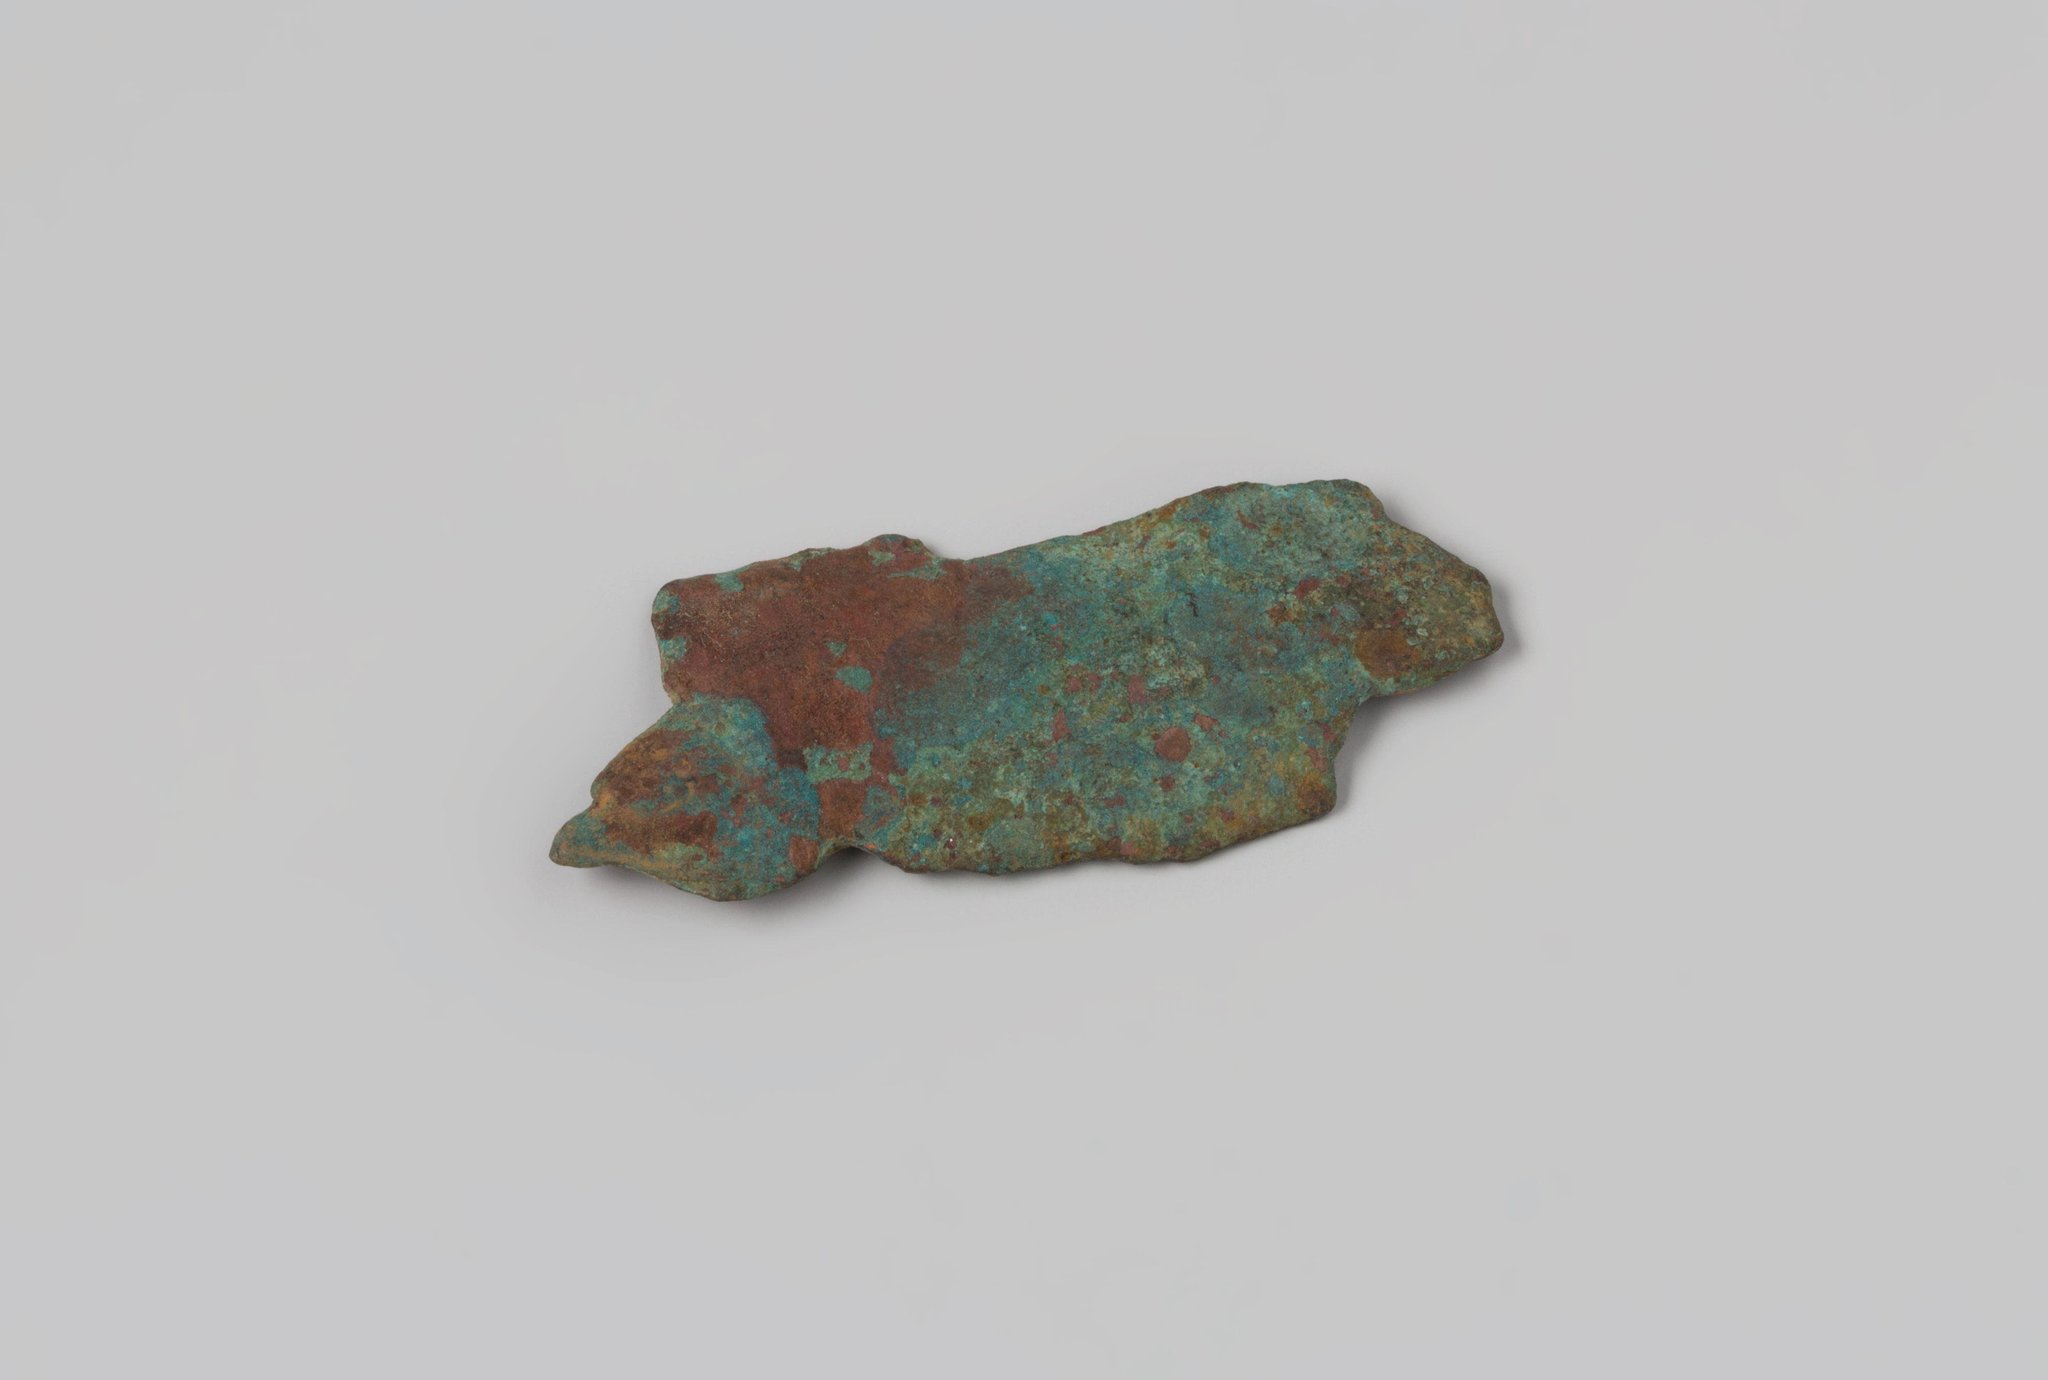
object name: scheepswrakvondst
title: Fragment van koper uit het wrak van de Oost-Indiëvaarder Hollandia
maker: Anonymous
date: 1700-1743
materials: copper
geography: netherlands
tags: verenigde oostindische compagnie, hollandia (schip), annet